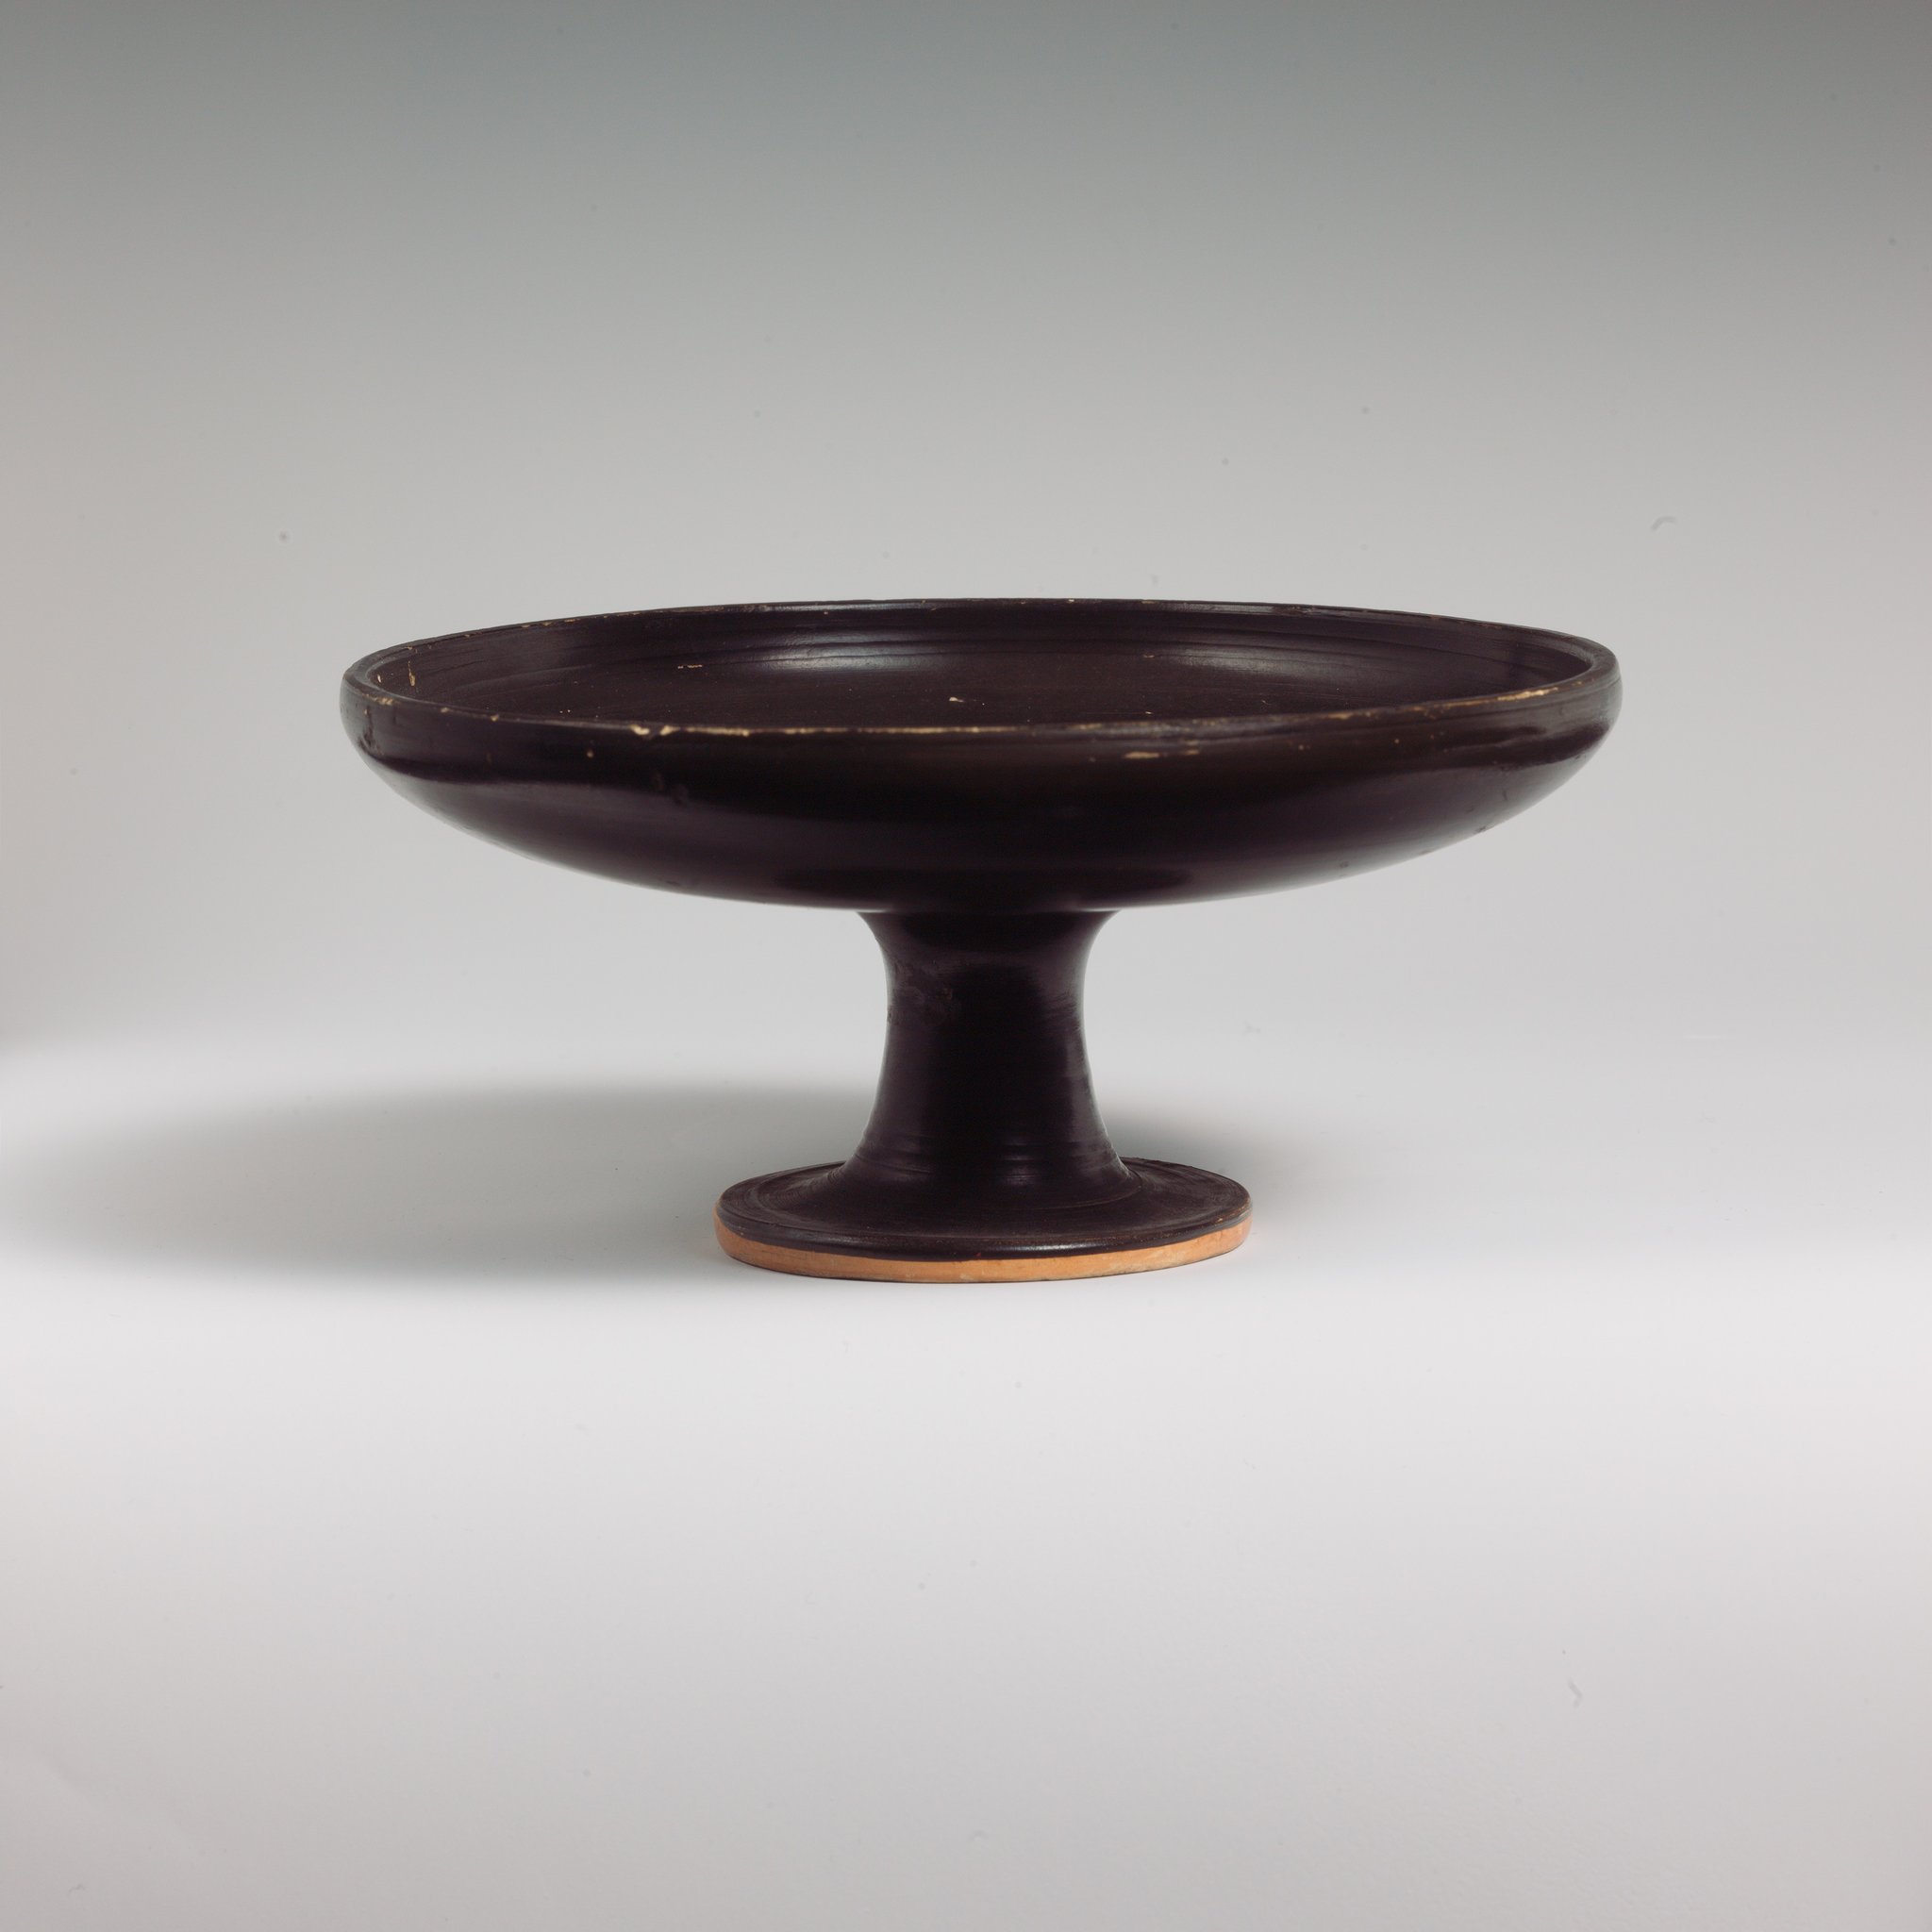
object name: stemmed dish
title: Terracotta stemmed dish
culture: greek, attic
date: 500-401 BCE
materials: terracotta